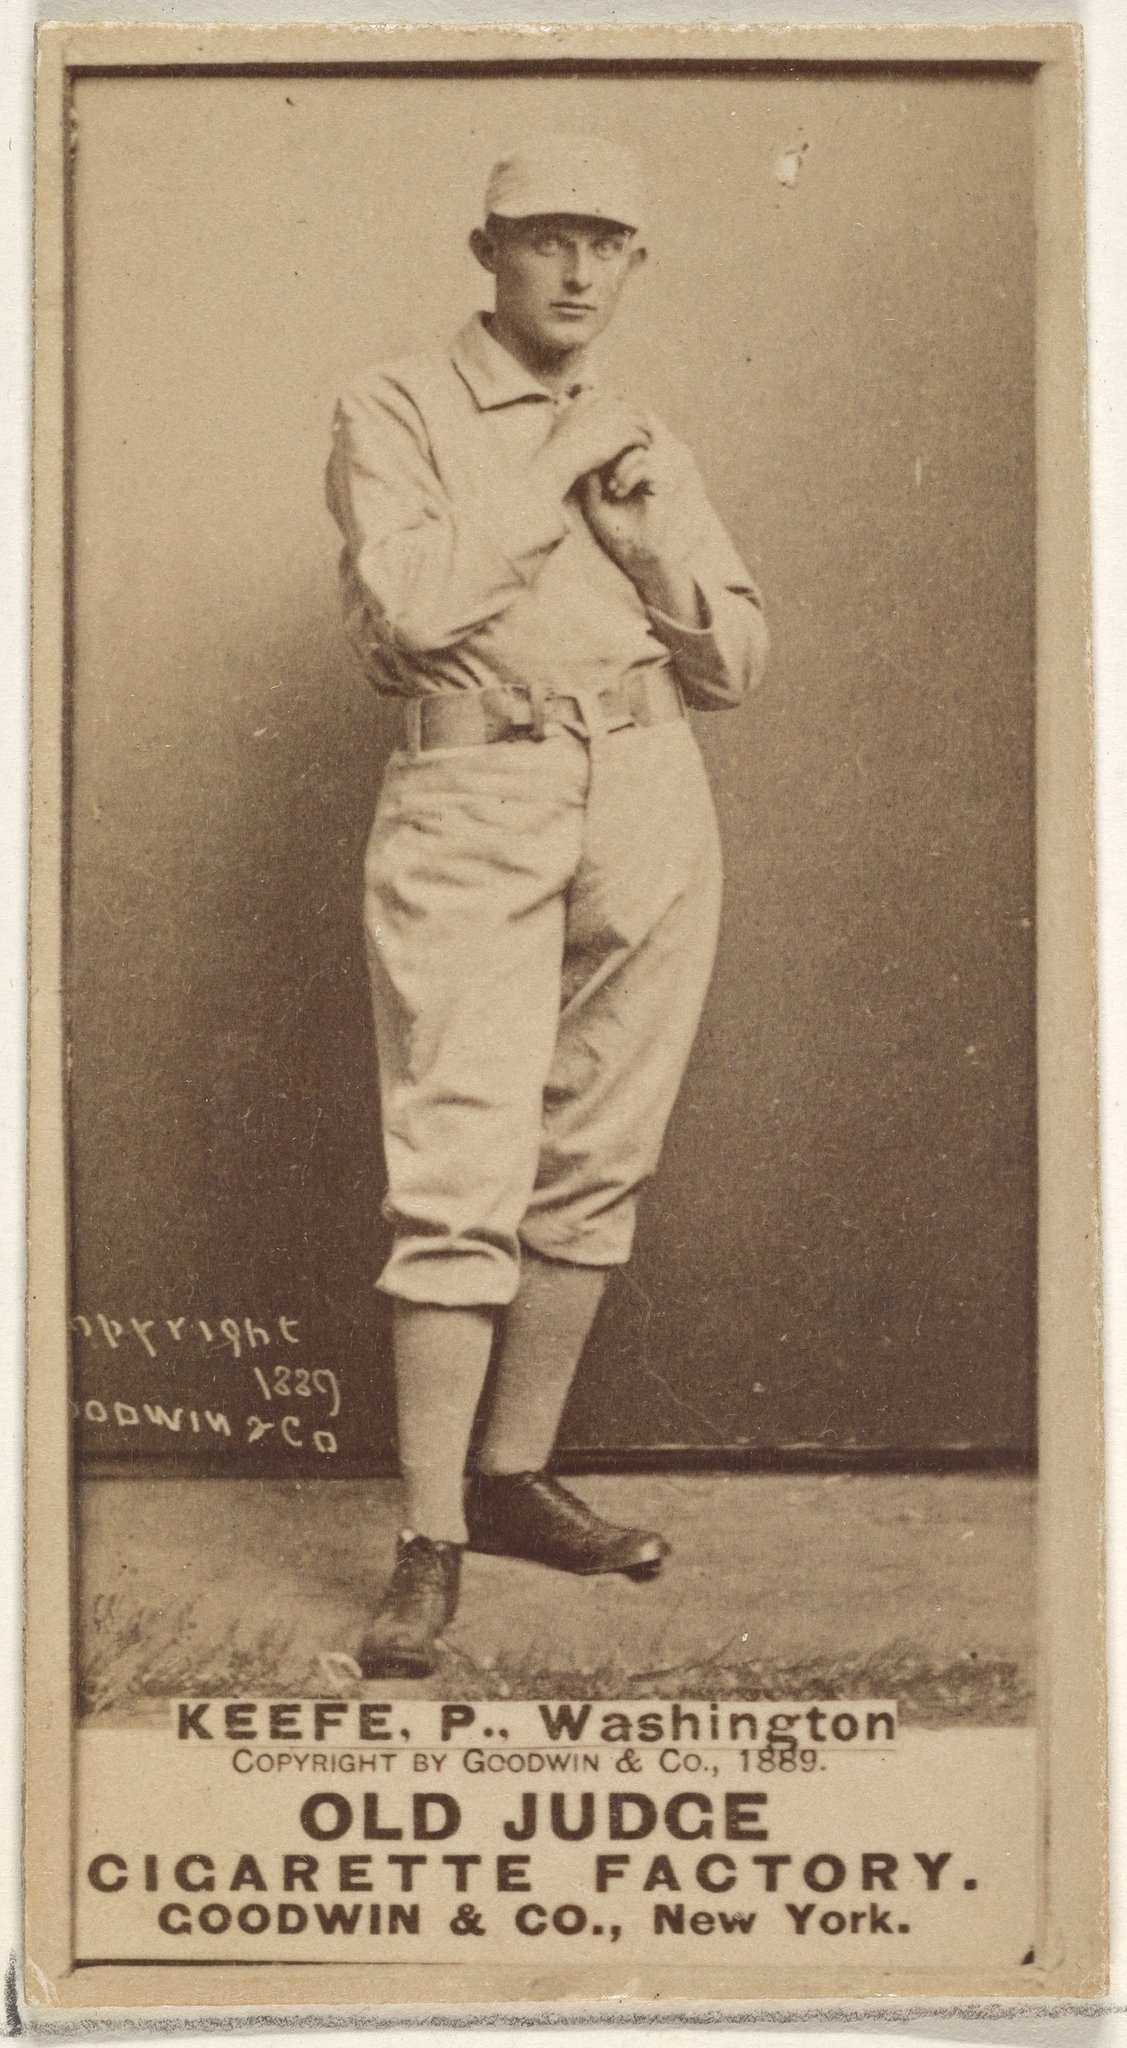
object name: baseball card, photograph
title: George Washington Keefe, Pitcher, Washington Nationals, from the Old Judge series (N172) for Old Judge Cigarettes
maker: goodwin & company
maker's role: publisher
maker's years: 1850-1950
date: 1889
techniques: albumen silver print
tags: men,portraits,baseball,athletes